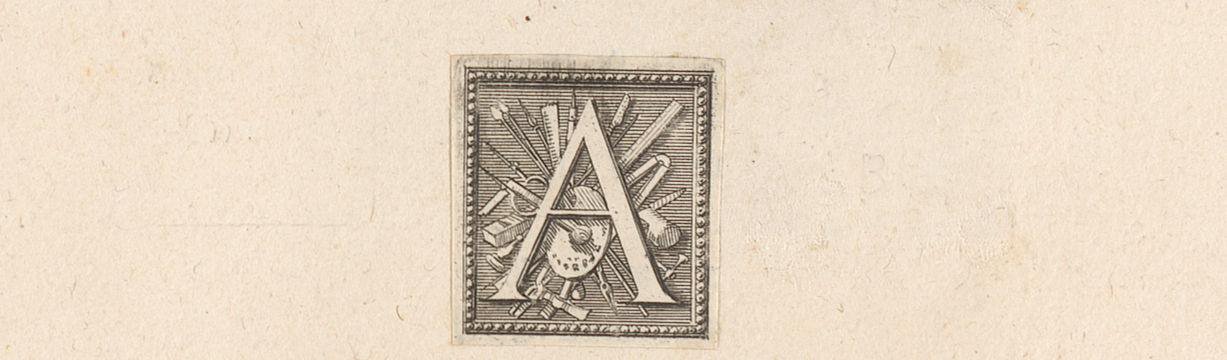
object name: book illustration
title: Initiaal 'A' met schilders attributen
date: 1676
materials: paper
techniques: etching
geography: paris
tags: initial, palette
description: Prent uit: Félibien, André. Des principes de l'architecture (...). Parijs: Jean-Baptiste (I) Coignard, 1676.